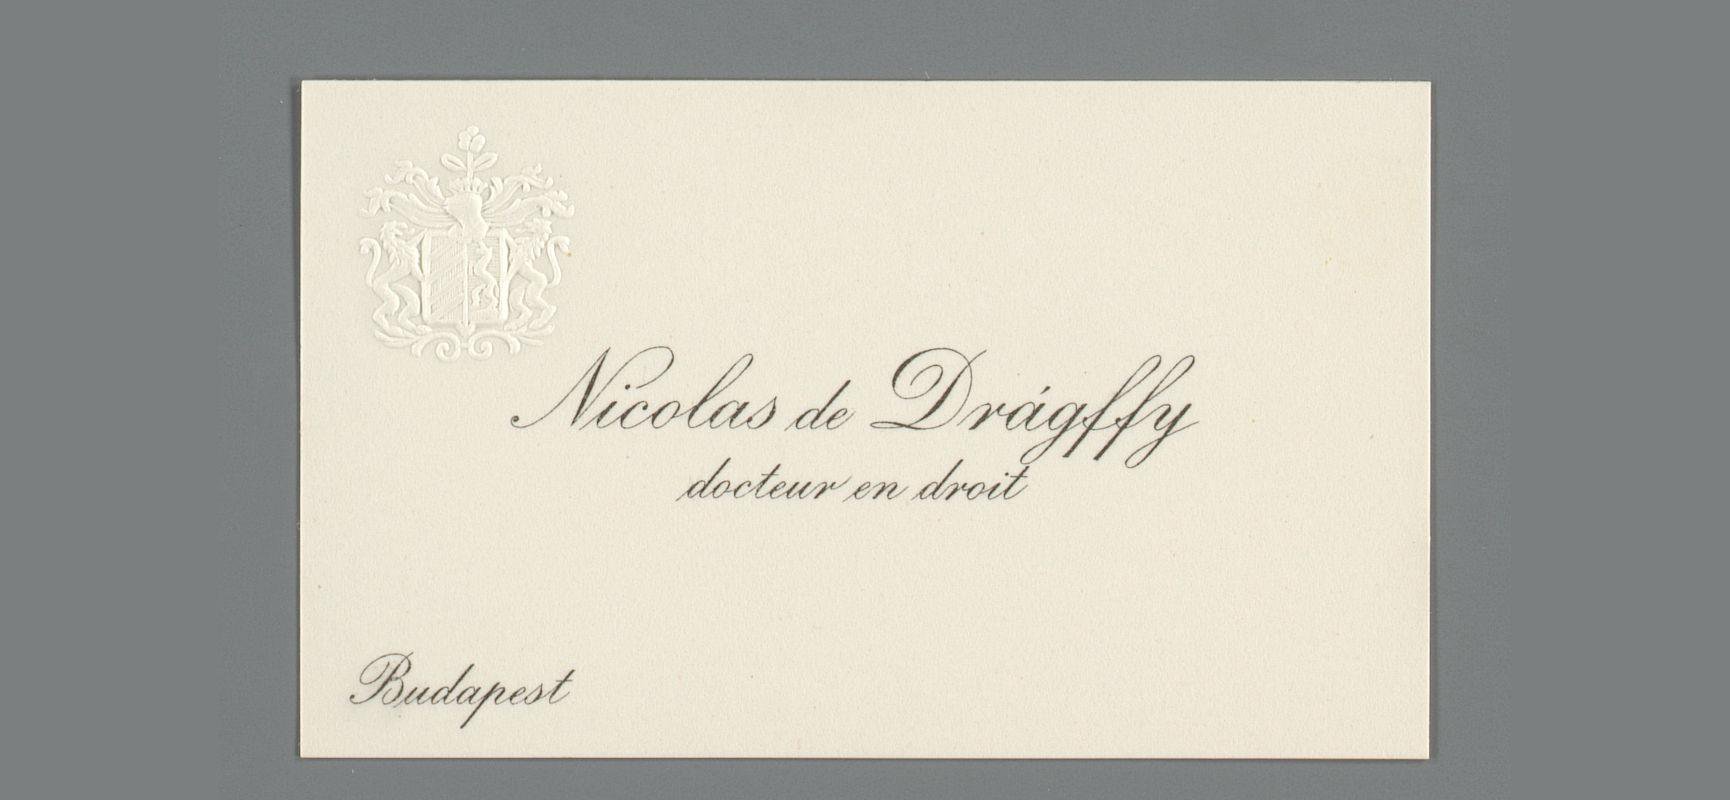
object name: photomechanical print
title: Verlovingsaankondiging van Lily van Peski en Nicolas de Drágffy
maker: Anonymous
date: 1936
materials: paper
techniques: printing, printing block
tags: betrothal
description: Kaart met de naam van Nicolas de Drágffy, met daaronder: 'docteur en droit. Budapest' evenals een blindgestempeld familiewapen.